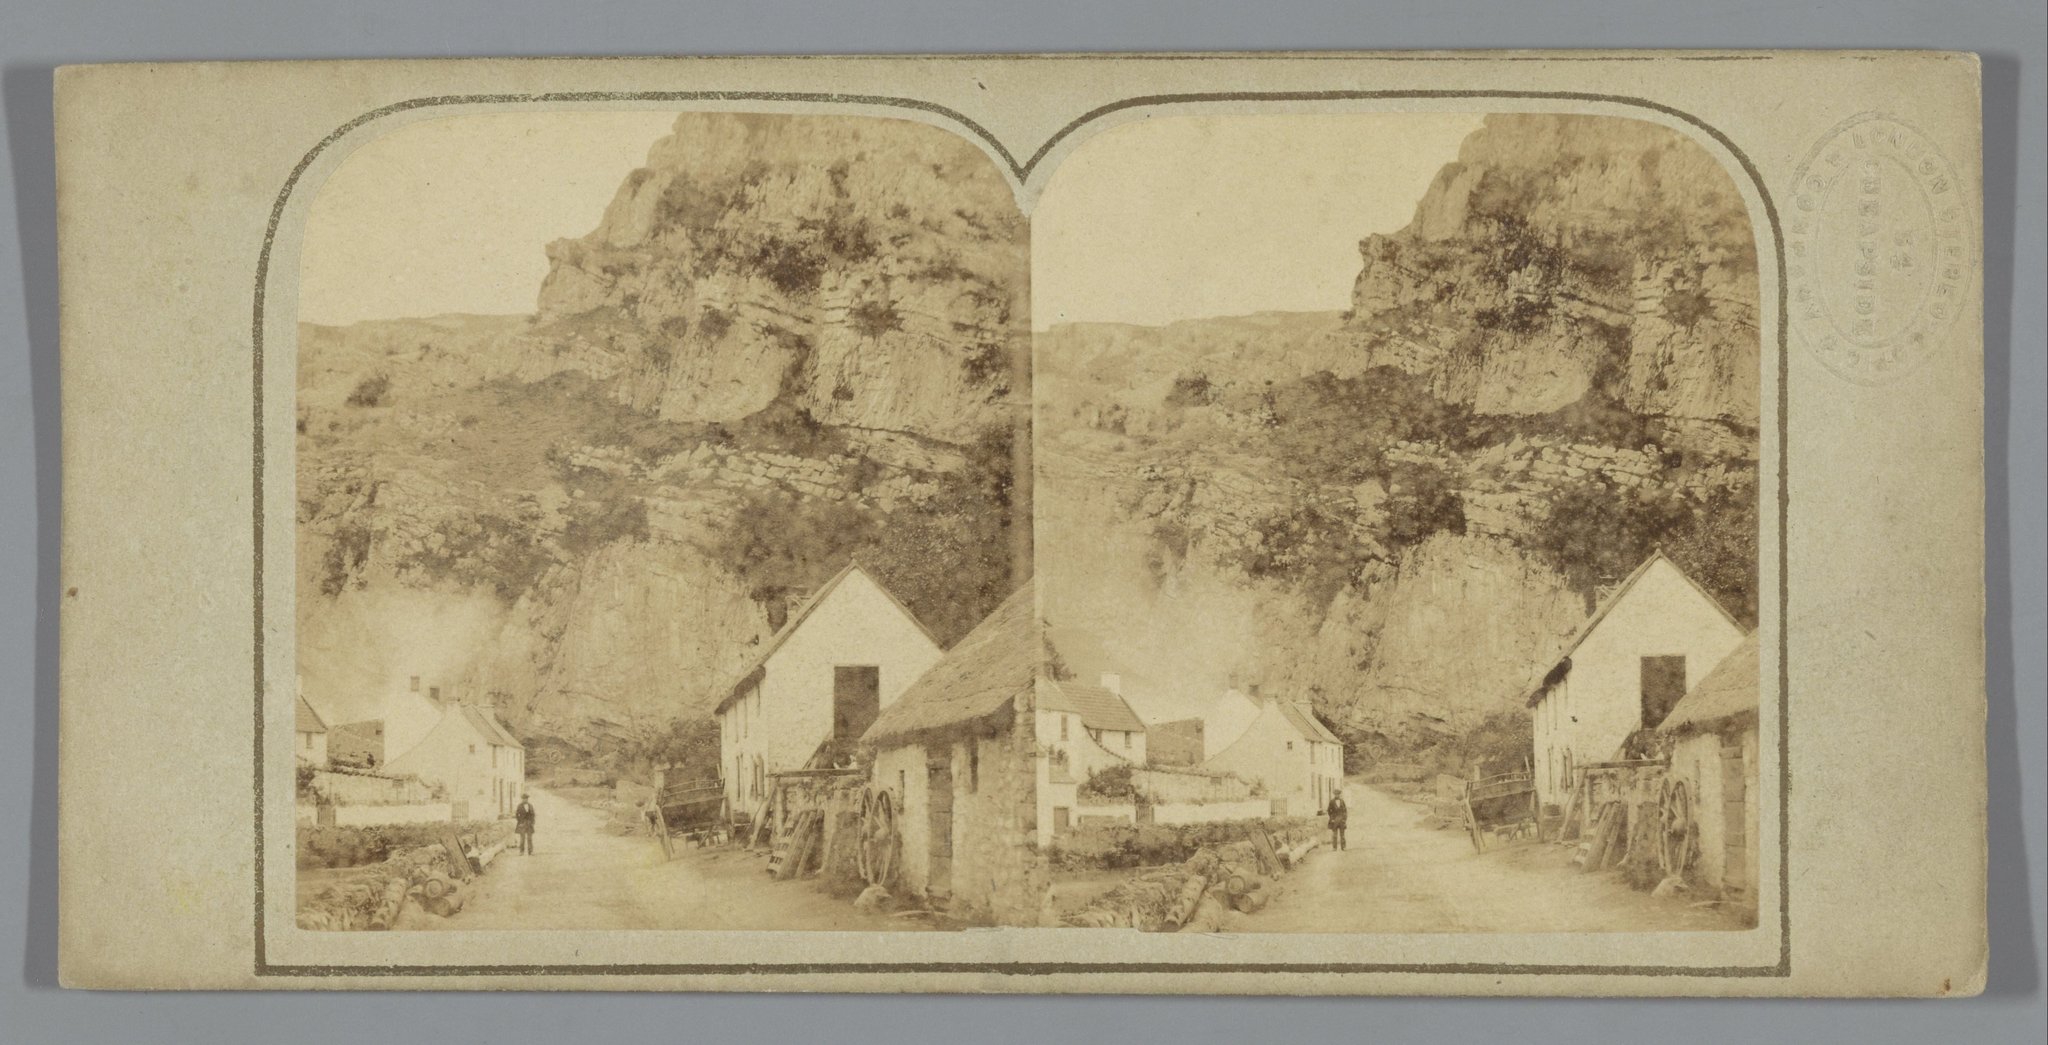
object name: stereograph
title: Cheddar, Somersetshire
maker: Anonymous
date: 1854-1859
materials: cardboard, paper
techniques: albumen print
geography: cheddar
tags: street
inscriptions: inscription: ‘No 10/ +/ 1.75’, inscription: ‘No 8/ 1’